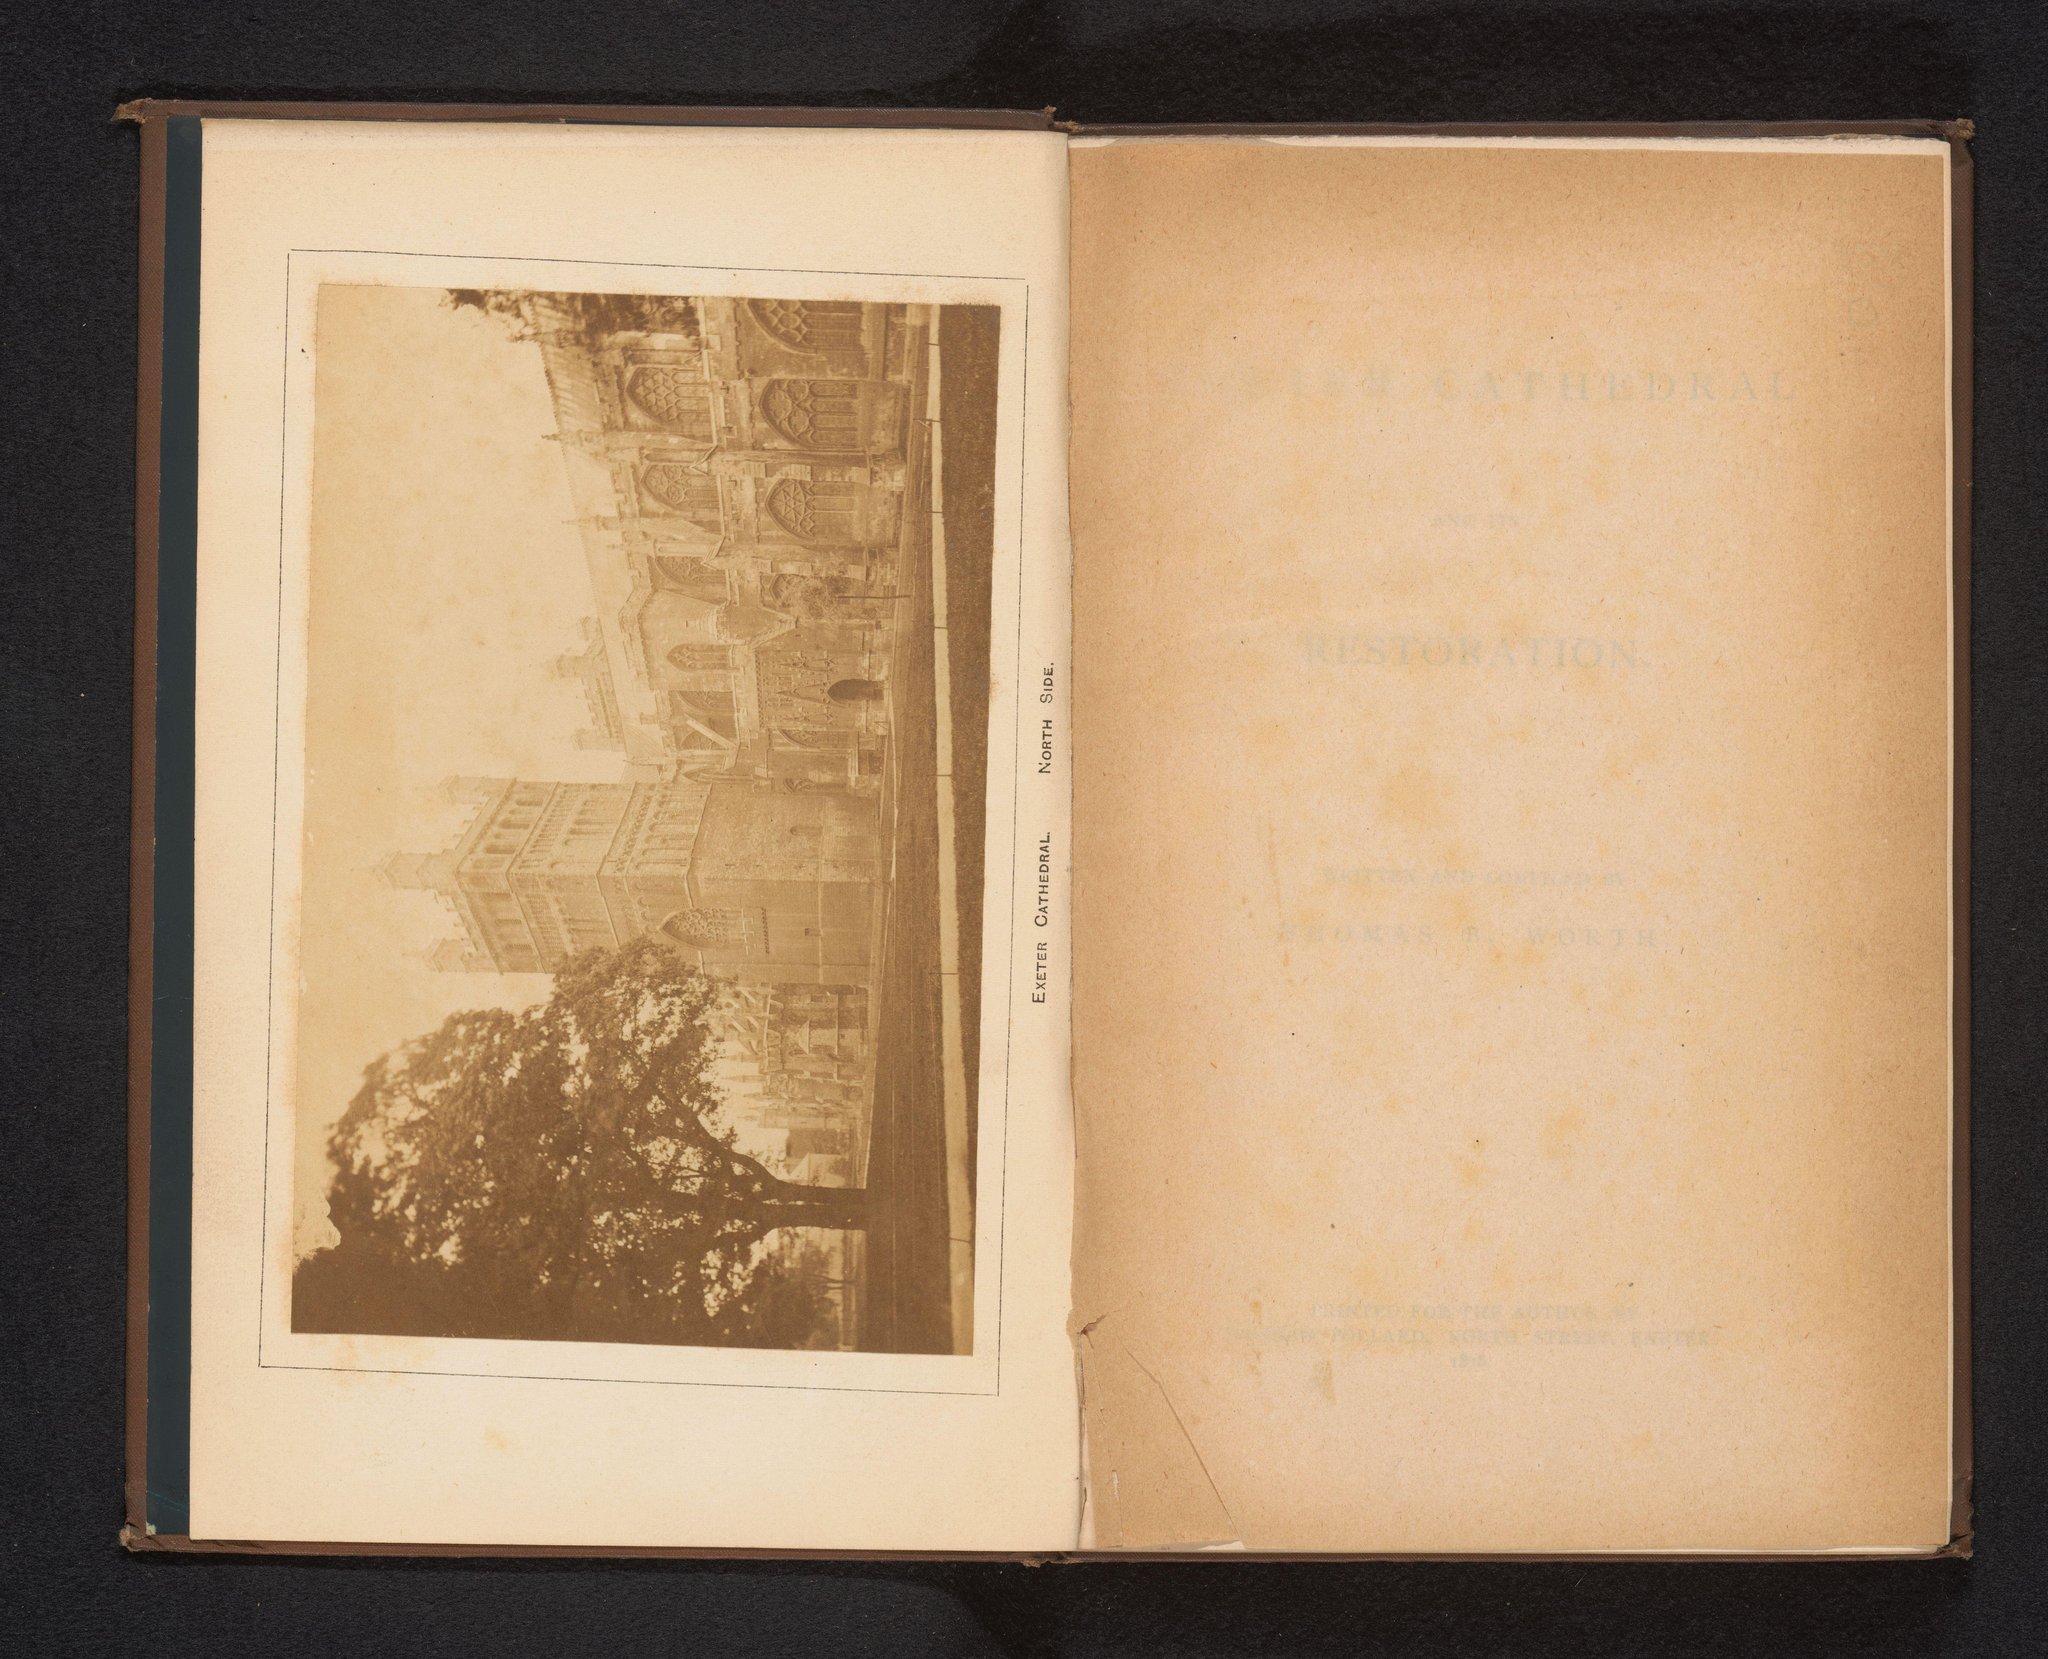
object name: photograph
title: Exeter Cathedral, North side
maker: Anonymous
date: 1873-1878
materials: photographic support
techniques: albumen print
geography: exeter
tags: church (exterior)